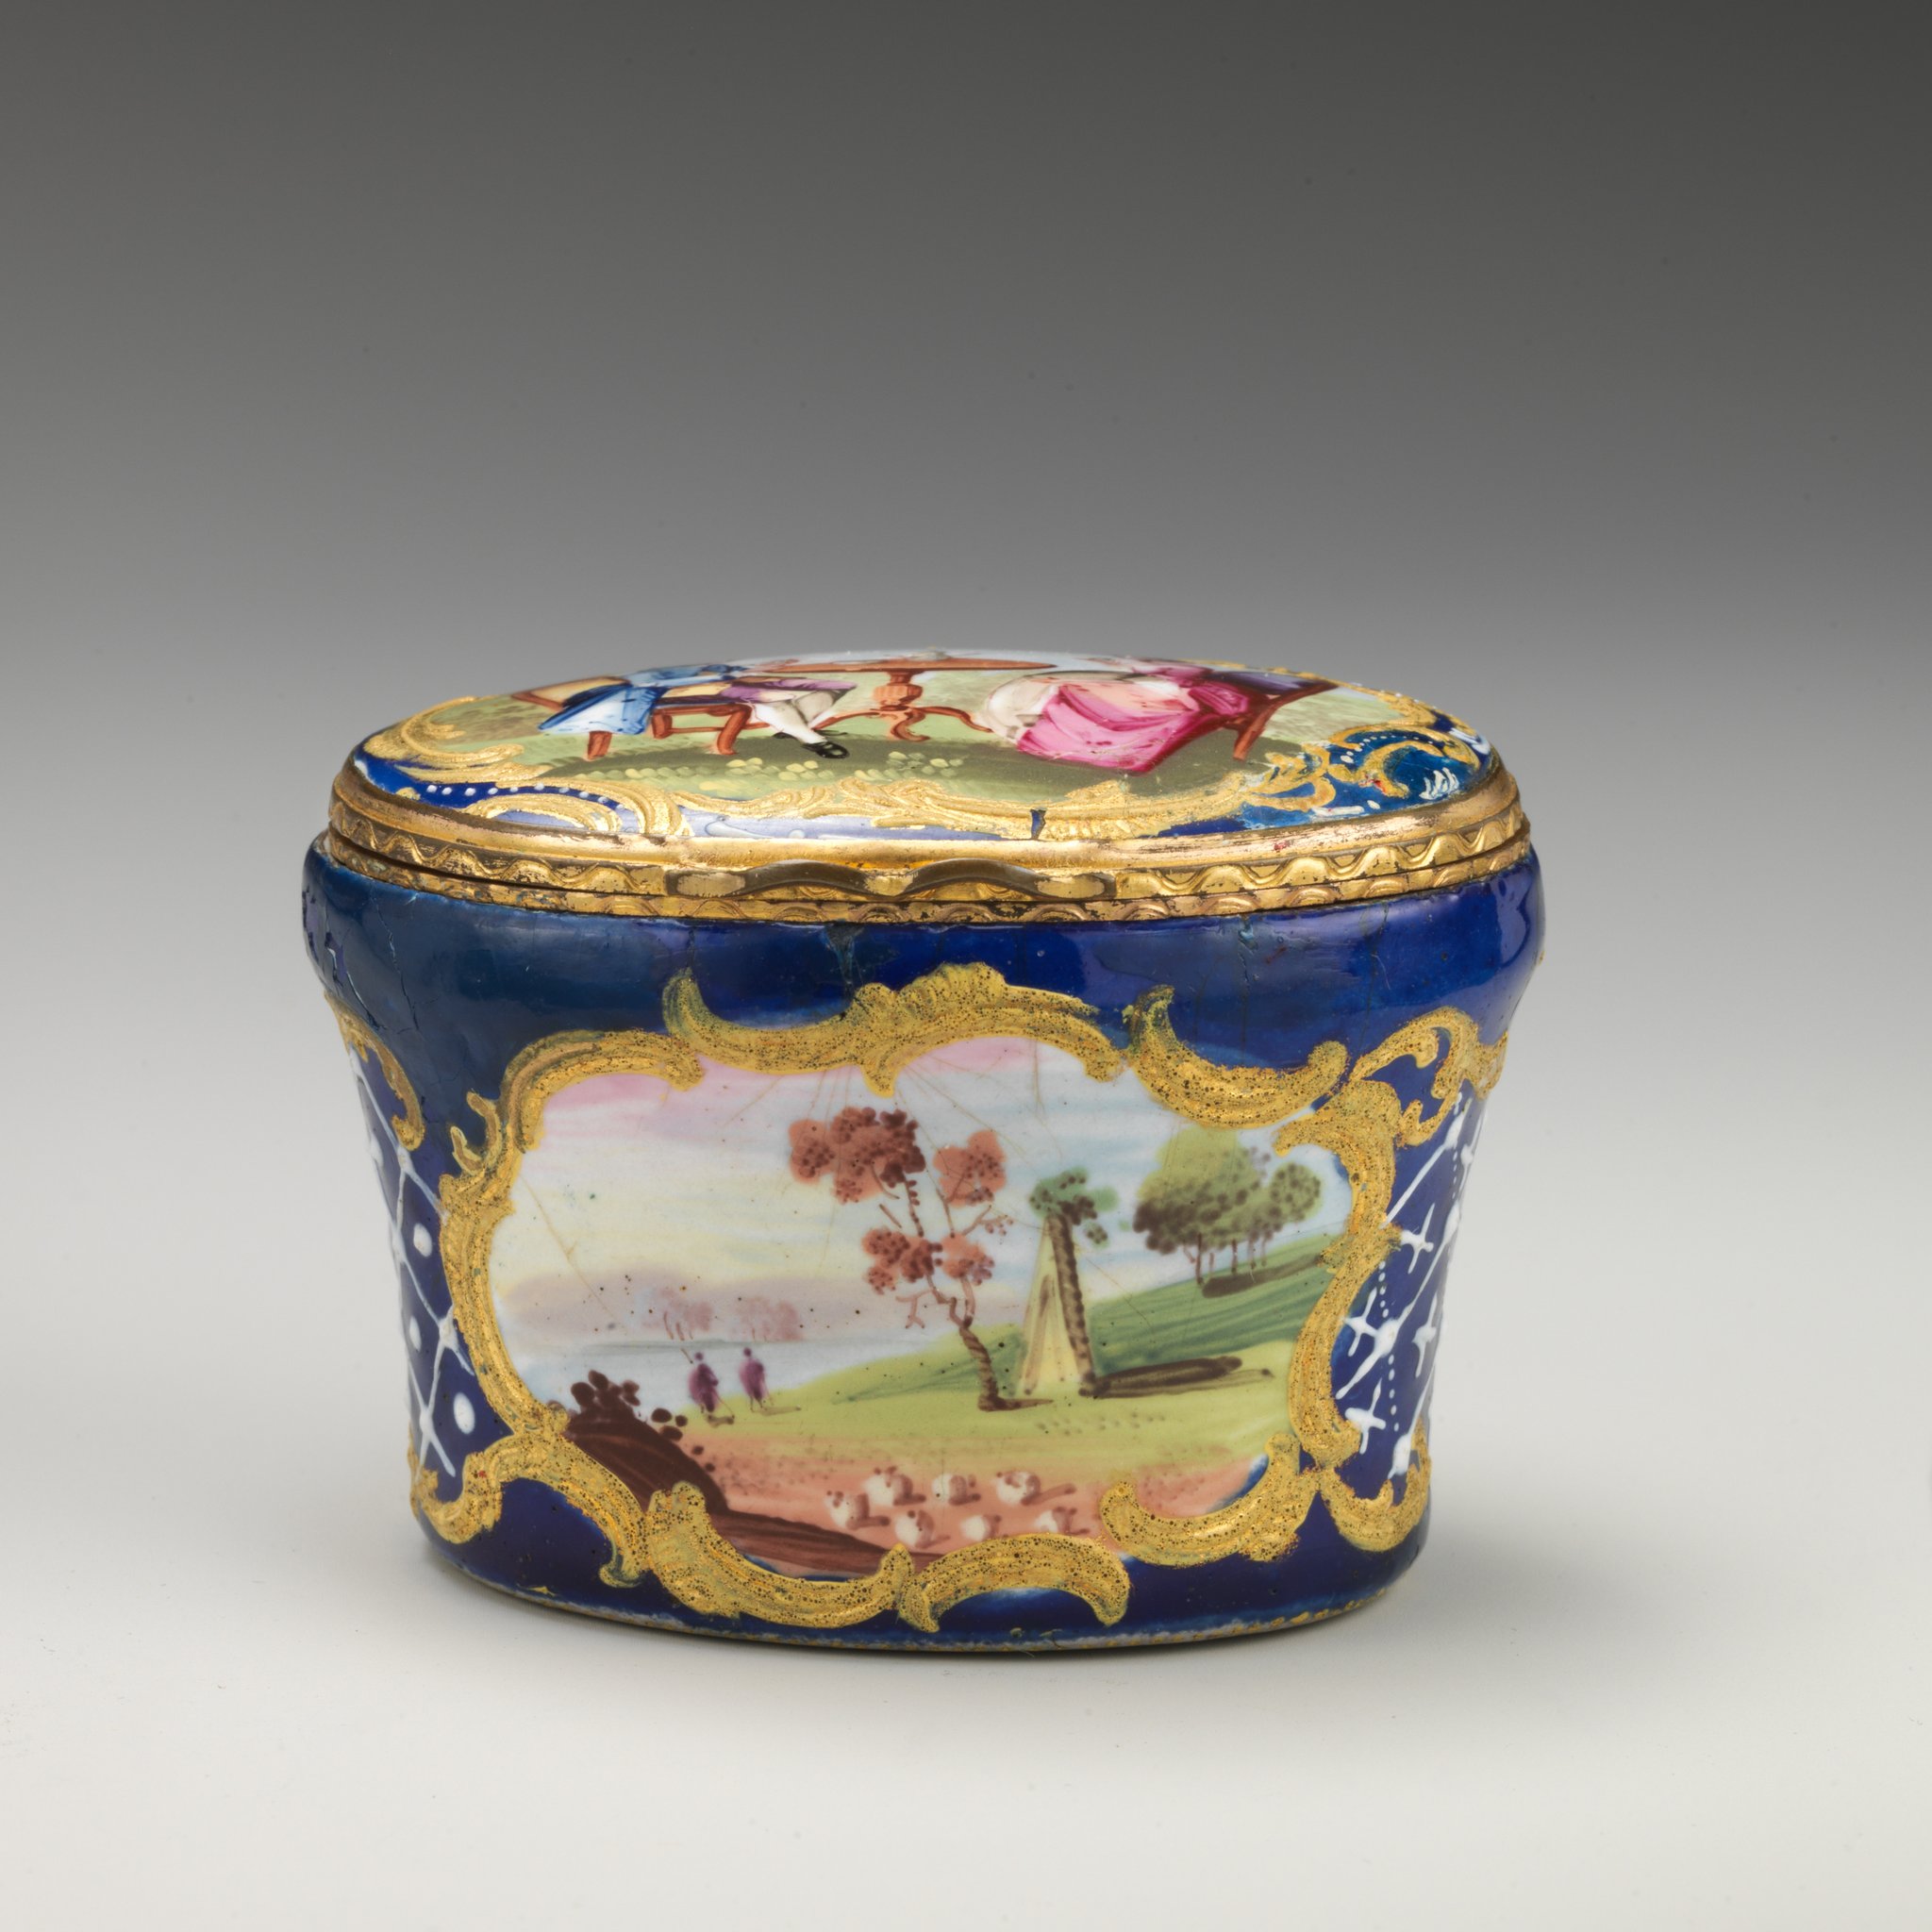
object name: bonbonnière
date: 1780-1790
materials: copper, enamel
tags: animals,trees